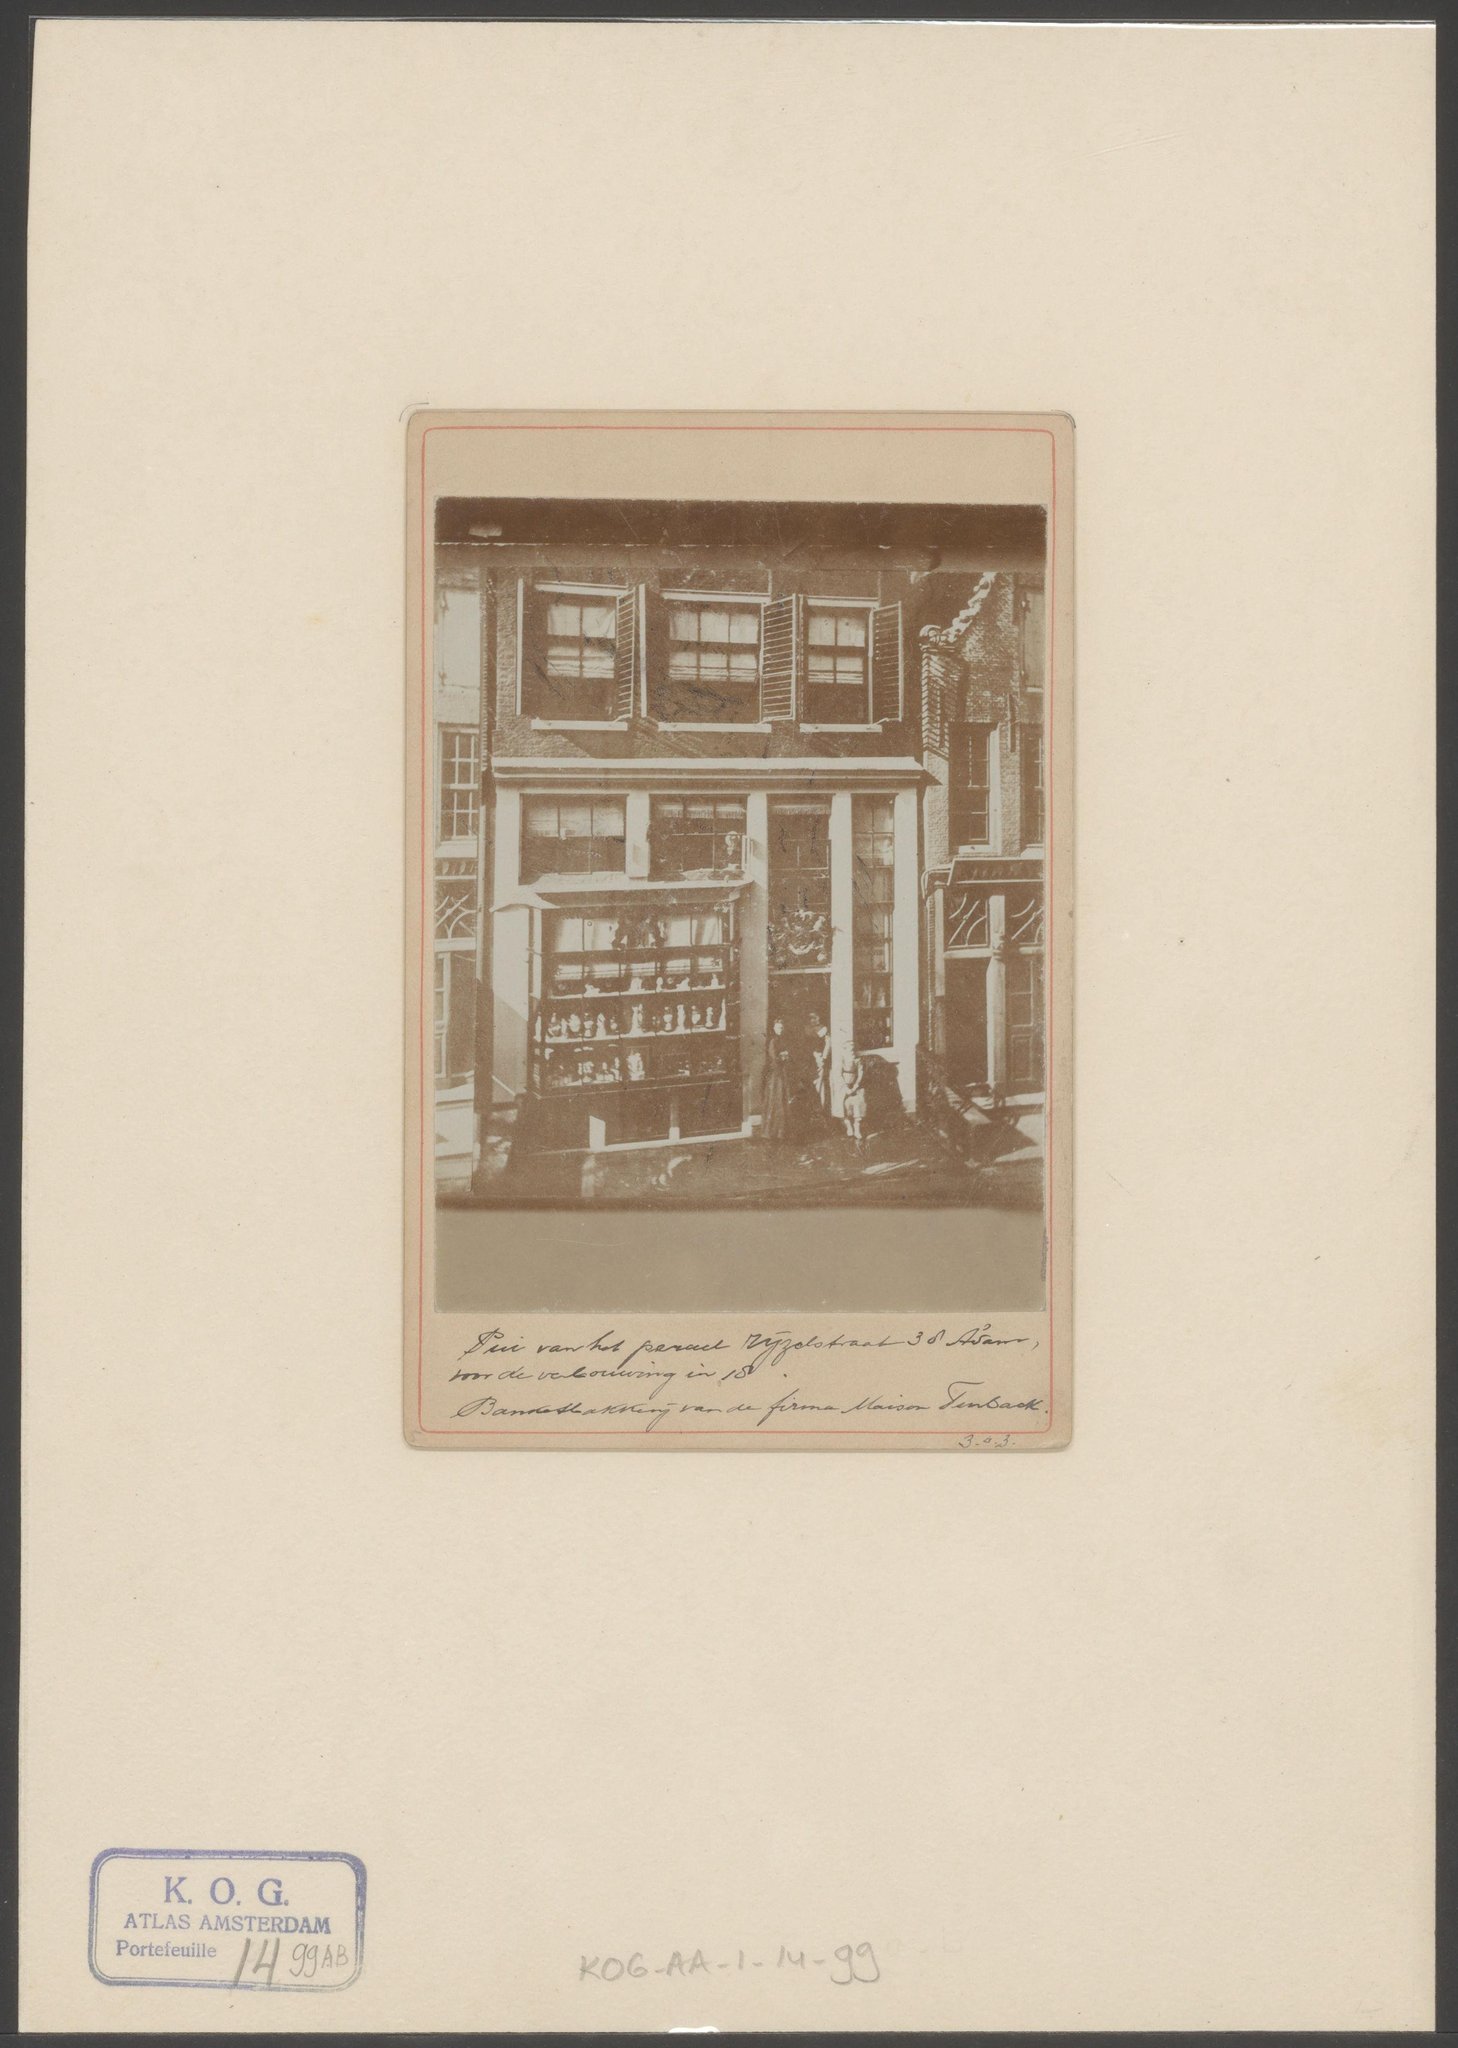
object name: cabinet photograph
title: Gezicht op de gevel van Vijzelstraat 38 voor de verbouwing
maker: Anonymous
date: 1918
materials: paper, cardboard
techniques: gelatin silver print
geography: amsterdam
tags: city-view in general; 'veduta', baker, façade (of house or building)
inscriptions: collector's mark: ‘14 99A’ Lugt 1641b, inscription: ‘Dit is ons (...) in Juni 1918’, collector's mark: ‘14 99AB’ Lugt 1641b, inscription: ‘Pui van het (...) firma Maison Tenback’, inscription: ‘Tenback. banketbakkerij / is (...) Wouters / beiden firmanten’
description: Onderwerpsrubriek binnen de Atlas Amsterdam: Voorburgwal (O.Z.), Voorweg, Vijgendam, Vijzelstraat.